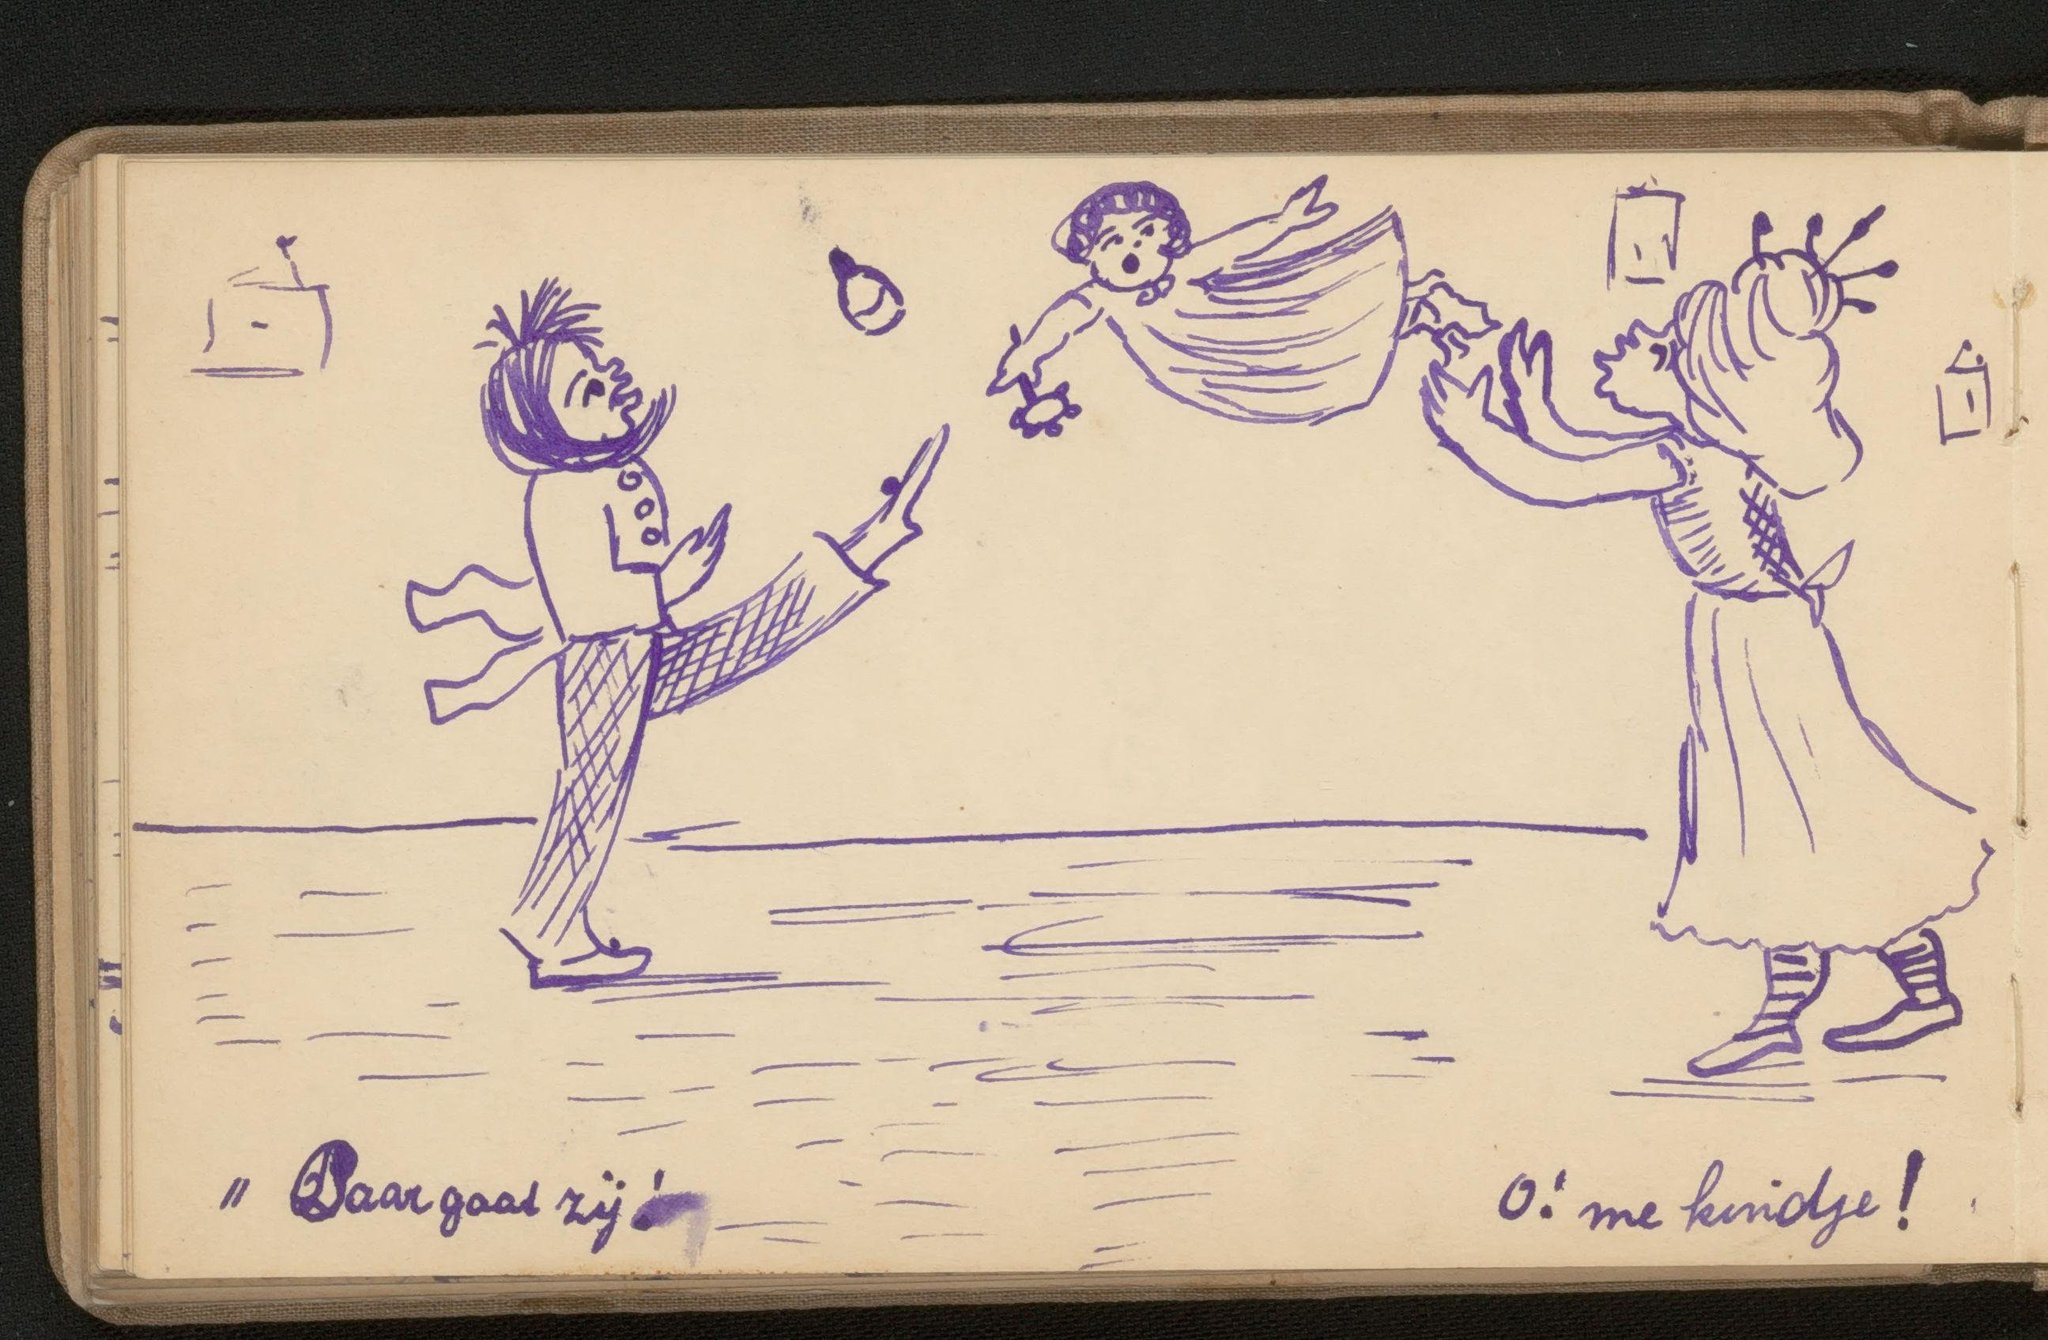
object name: sketchbook leaf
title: Daar gaat zij!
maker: Anonymous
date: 1875-1920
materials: ink, paper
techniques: pen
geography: netherlands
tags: infant, baby, parental love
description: Pa en Ma schoppen de baby door de kamer. Onderdeel van het schetsboek met humoristische tekeningen over het leven van een 'famille nombreuse'. Onderwerpsrubrieken binnen de Atlas Zeden en Gewoonten: Zeden en Gewoonten in Engeren Zin, Des menschen beging, midden en einde, Kinderleven.